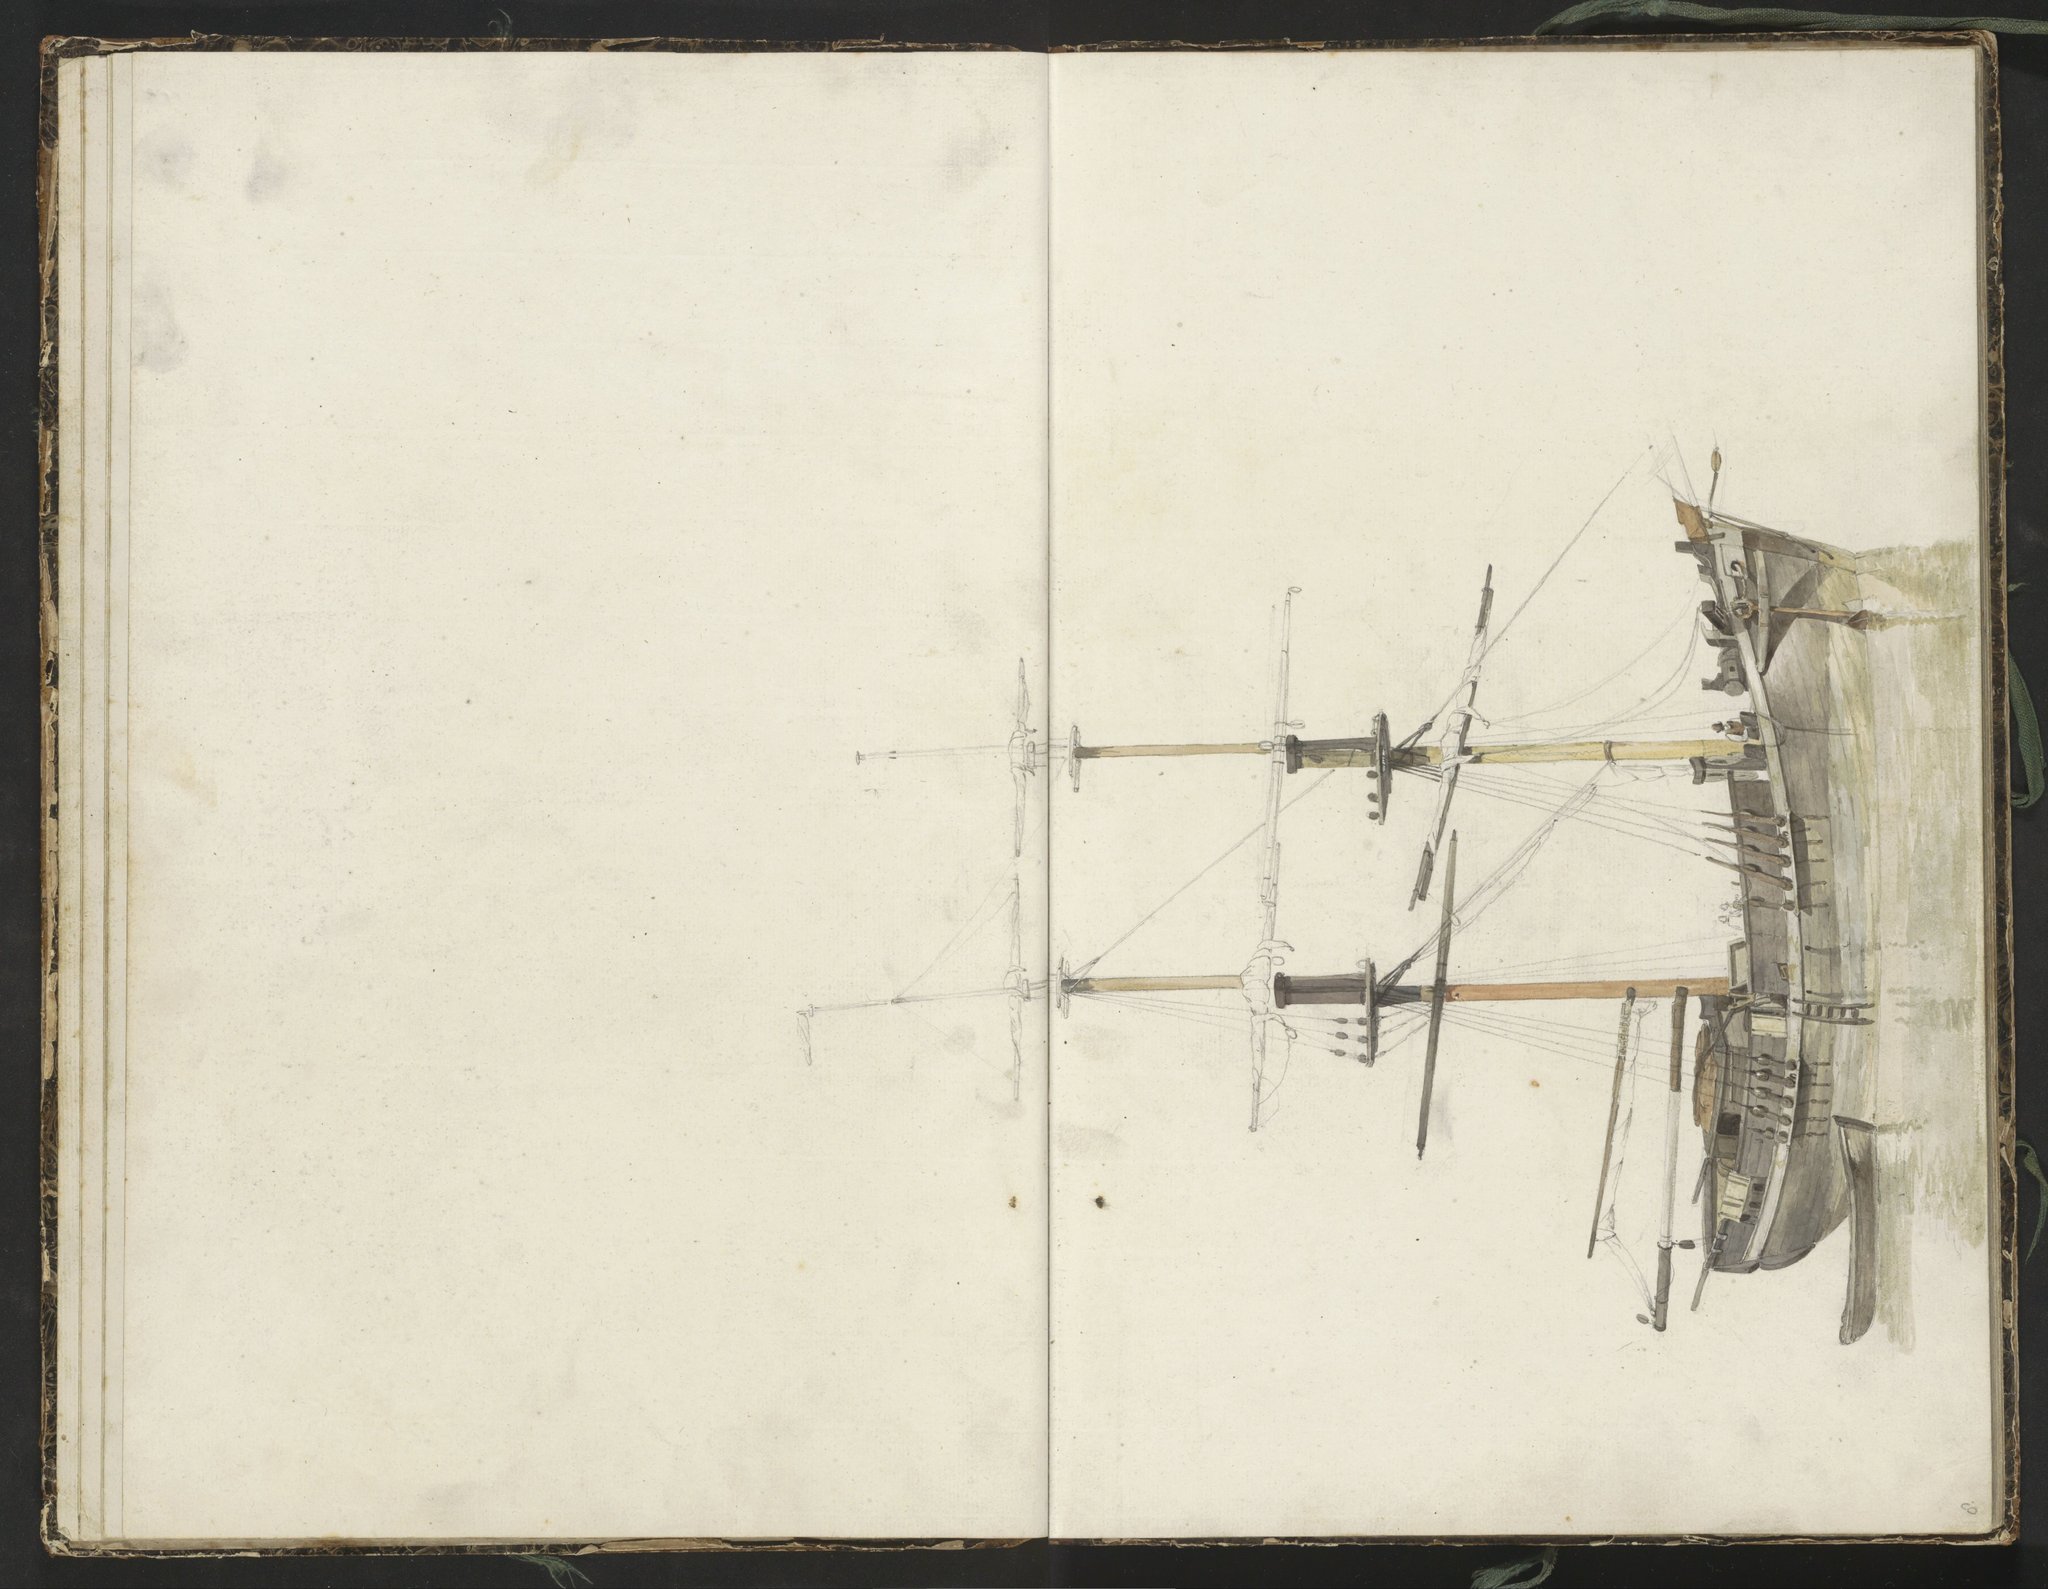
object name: sketchbook leaf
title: Figuren op een afgemeerde tweemaster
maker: johannes christiaan schotel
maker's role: draughtsman, painter, print maker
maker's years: 1787-1838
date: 1797-1838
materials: paper, pencil, watercolor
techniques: brush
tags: crew ~ ship, sailing-ship, sailing-boat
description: Blad 7 verso en 8 recto uit een schetsboek met 44 bladen.